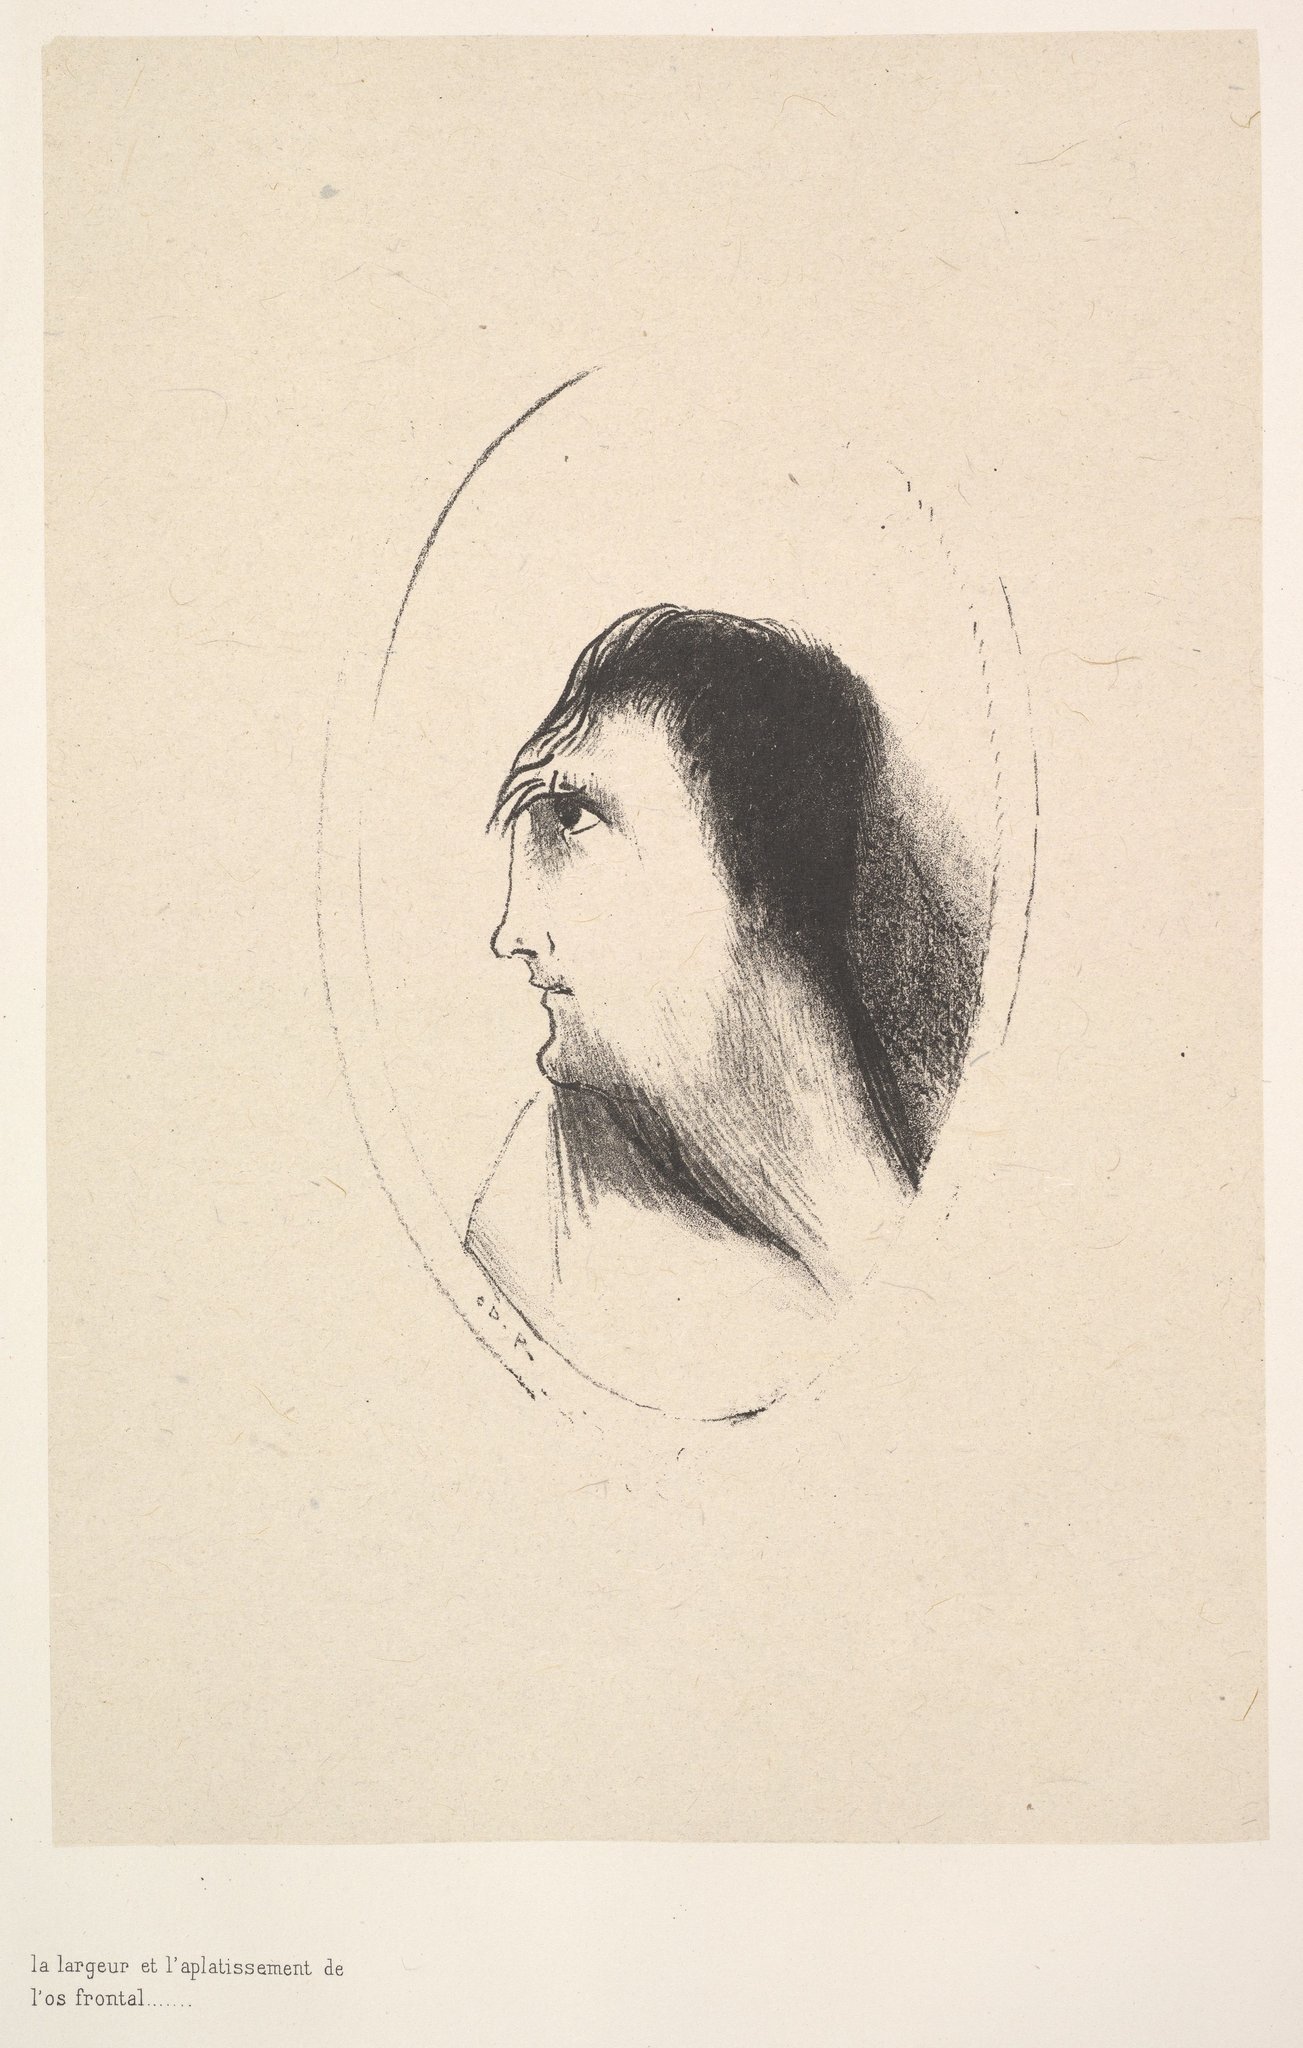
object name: print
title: The breadth and flatness of the frontal bone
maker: odilon redon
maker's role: artist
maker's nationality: french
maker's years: 1840-1916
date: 1896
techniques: lithograph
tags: profiles